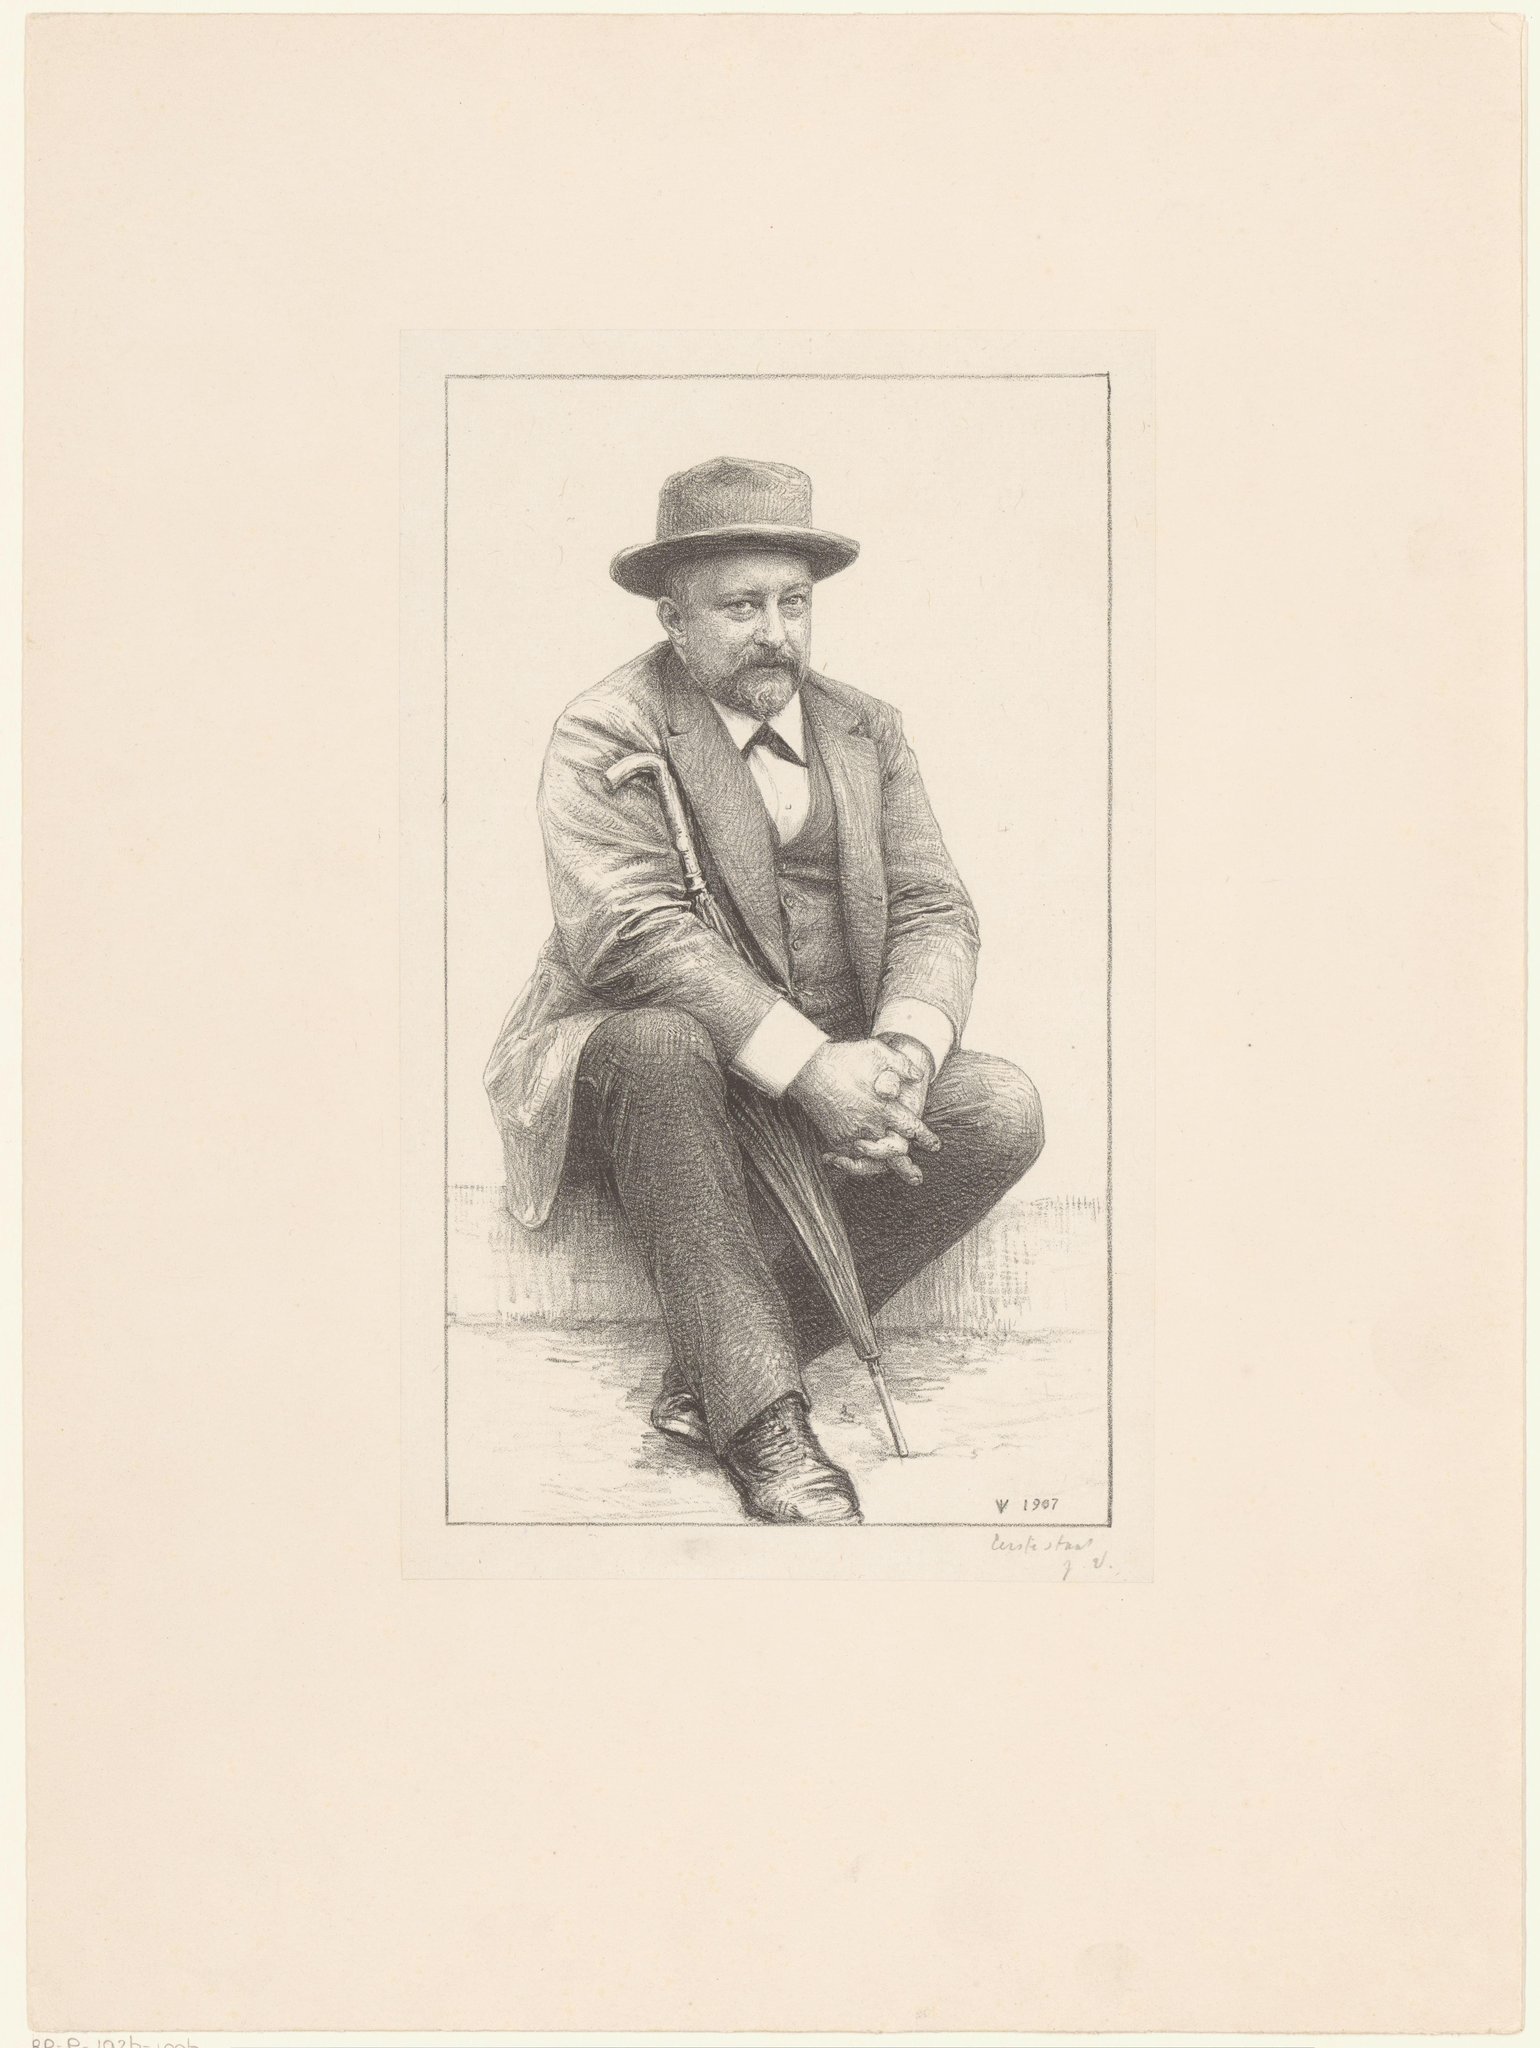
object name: print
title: Portret van Pieter Lodewijk Tak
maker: jan veth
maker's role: designer, draughtsman, painter, print maker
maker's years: 1864-1925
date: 1907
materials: paper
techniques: lithograph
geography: netherlands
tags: politician, pieter lodewijk tak, historical persons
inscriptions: inscription: ‘Eerste staat / J.V.’, collector's mark: Lugt 2228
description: Dit portret werd uitgegeven als bijvoegsel bij De Kroniek op 19 oktober 1907.